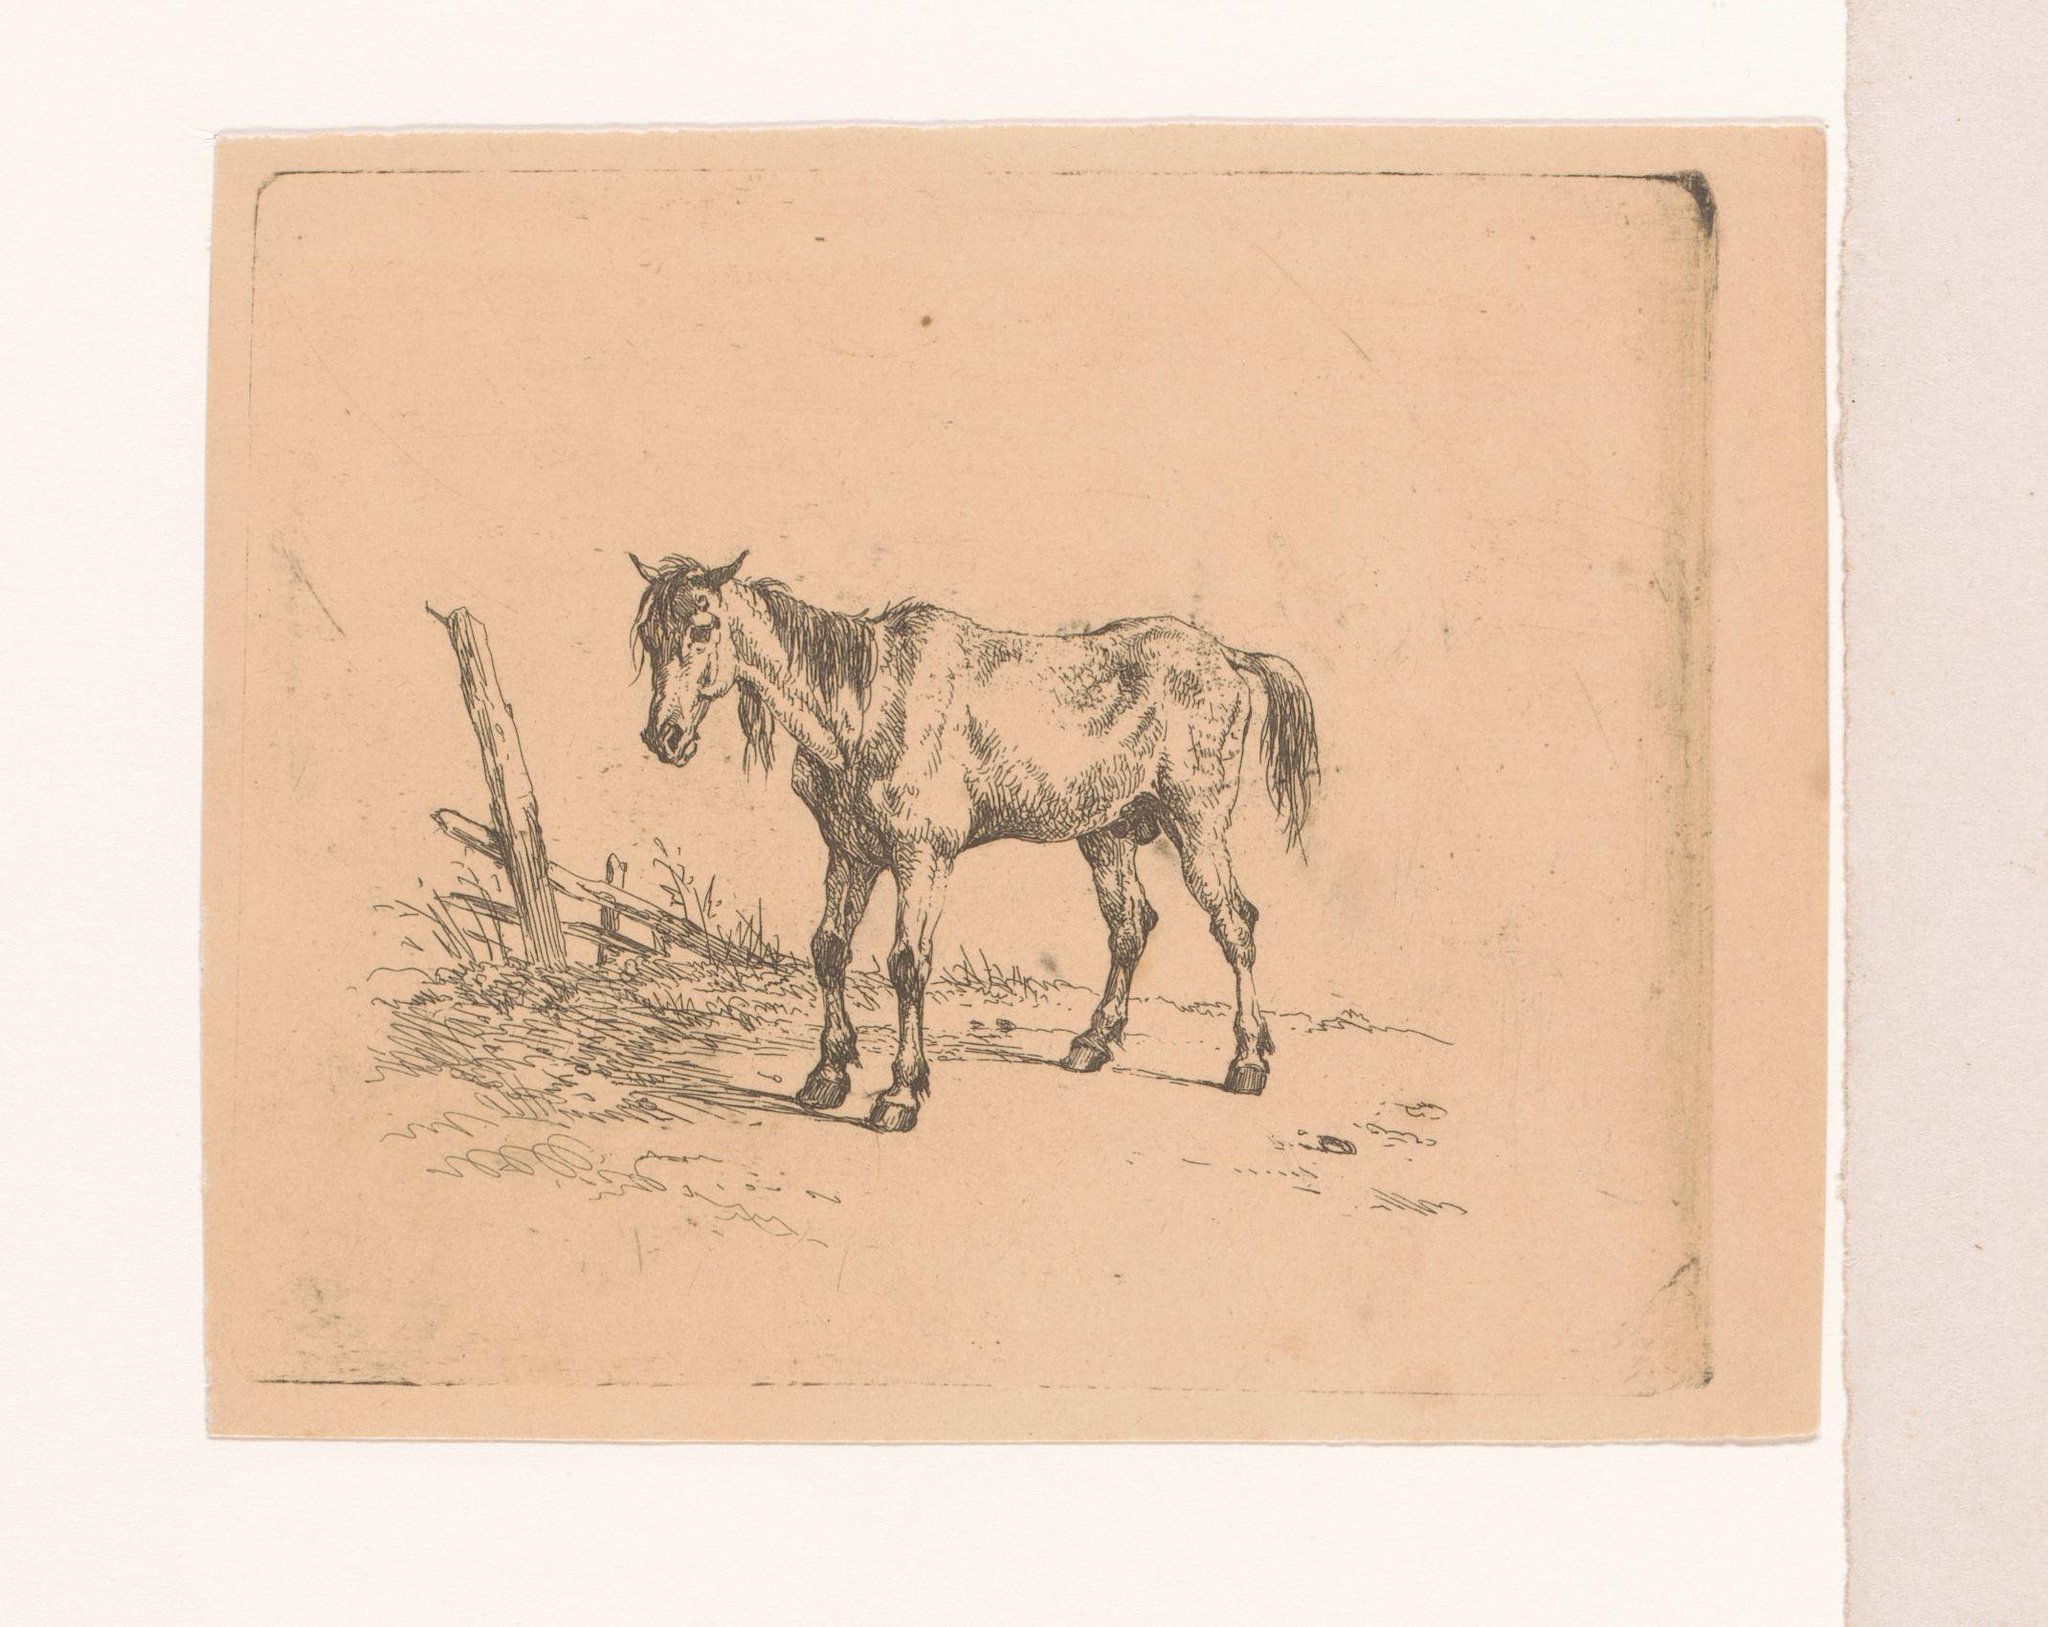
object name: print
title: Oud paard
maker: eugène verboeckhoven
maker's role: draughtsman, painter, print maker, printer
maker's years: 1798-1881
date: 1830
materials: paper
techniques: etching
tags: horse